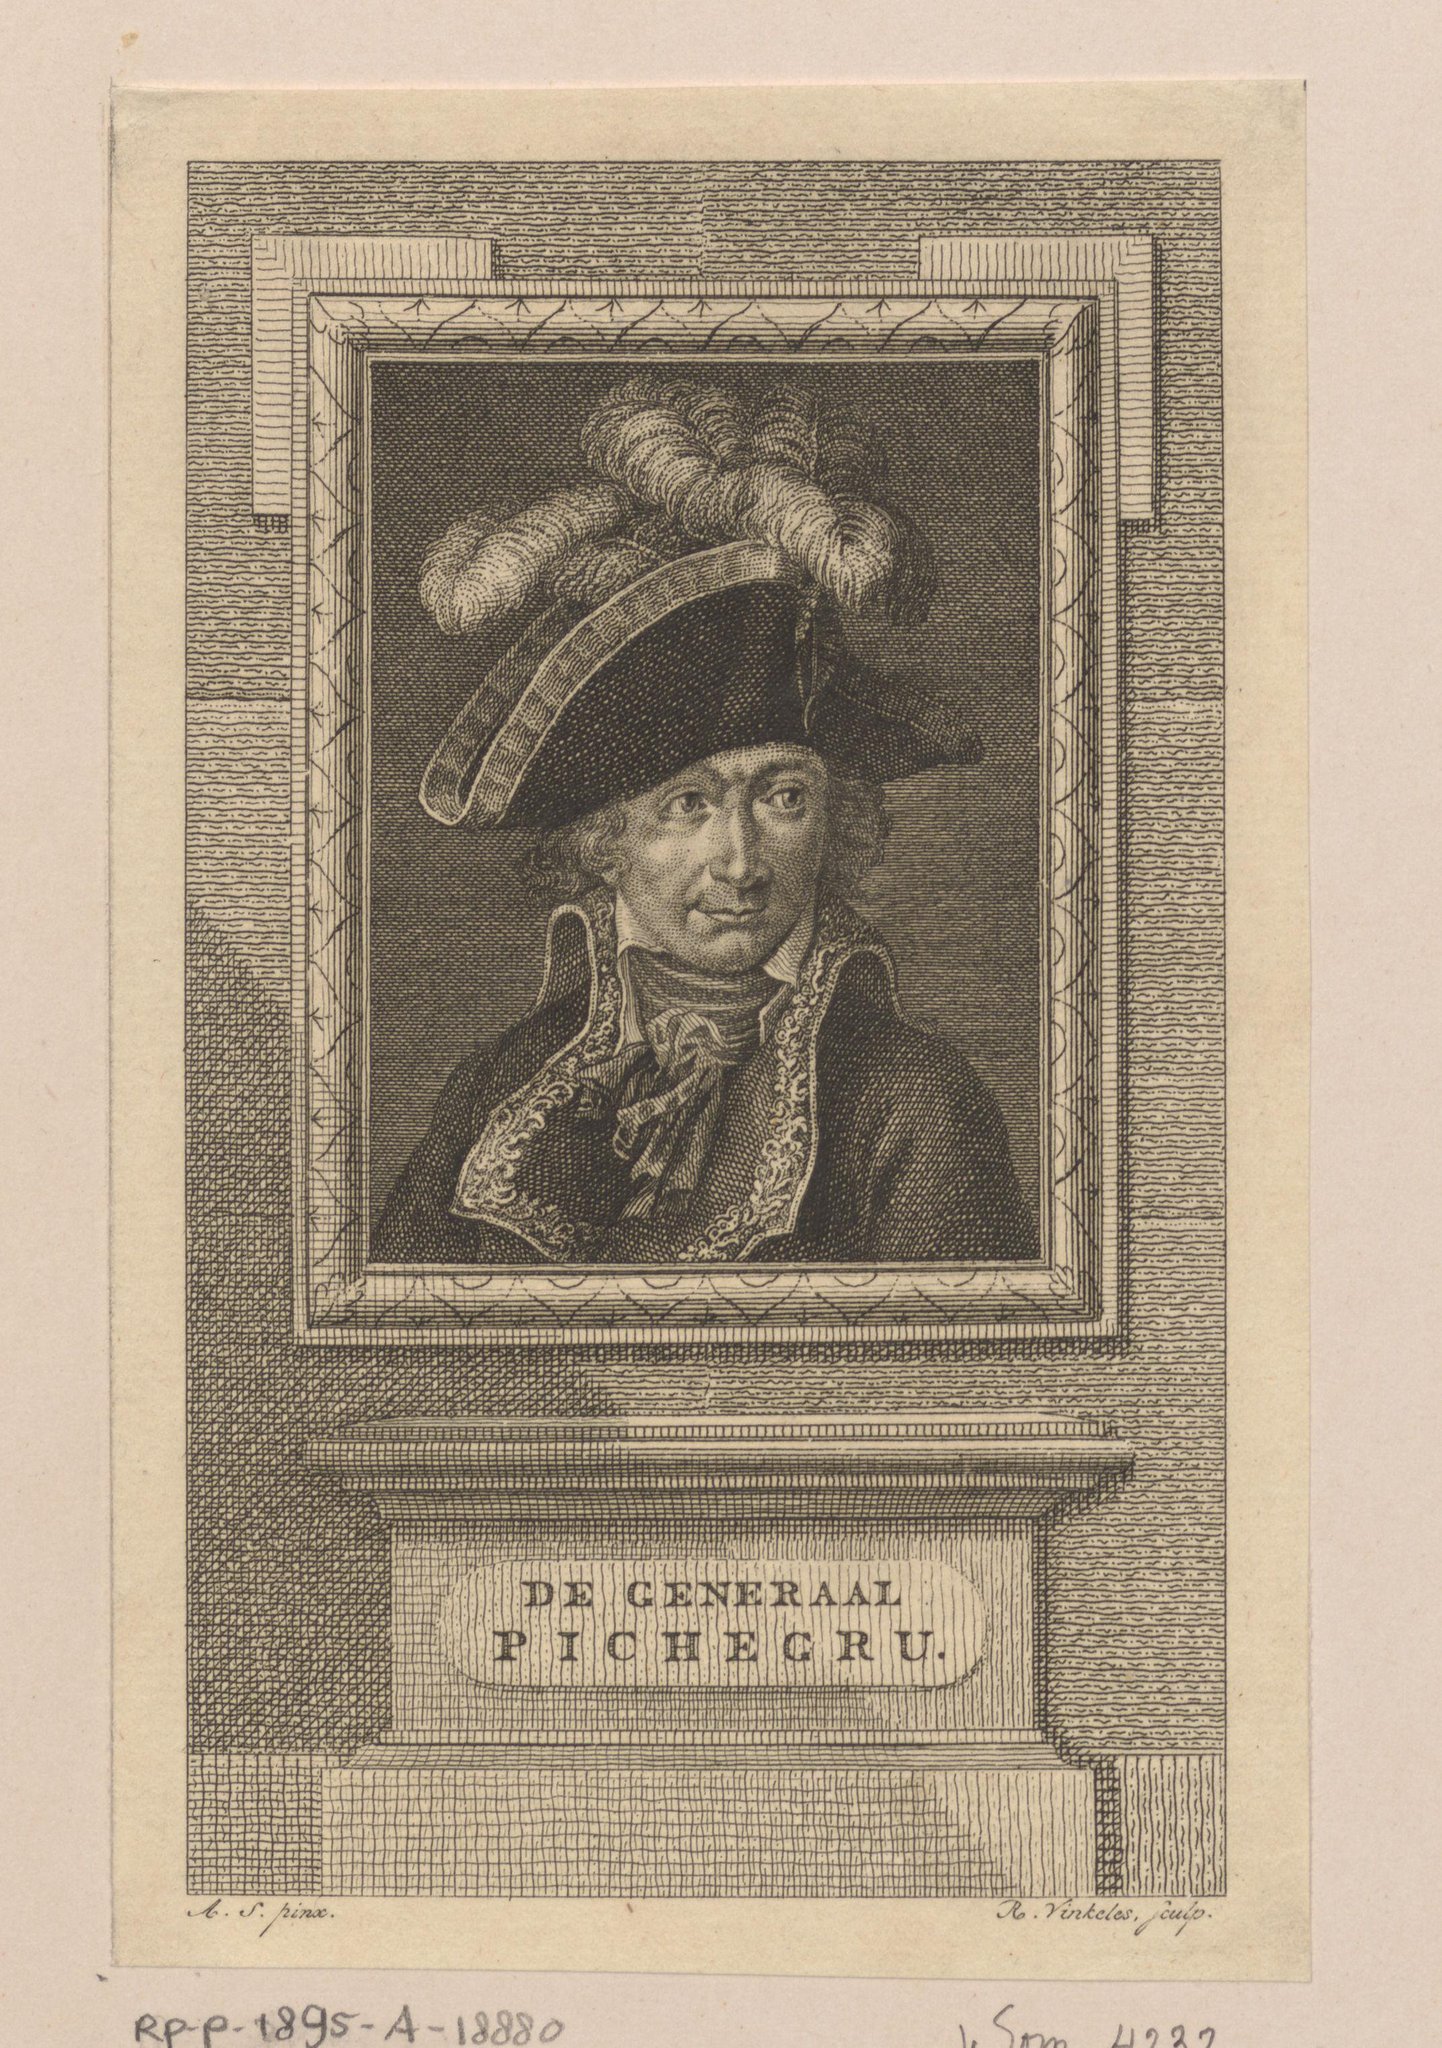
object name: print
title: Portret van Jean-Charles Pichegru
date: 1786-1809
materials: paper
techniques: engraving, etching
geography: amsterdam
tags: politician, jean-charles pichegru, commander-in-chief, general, marshal, historical persons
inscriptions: collector's mark: Lugt 2228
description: Prent mogelijk uit: Wagenaar, Jan. Vaderlandsche historie, (...) ten vervolge van Wagenaars Vaderlandsche historie. Amsterdam: Johannes Allart, 1786-1809.